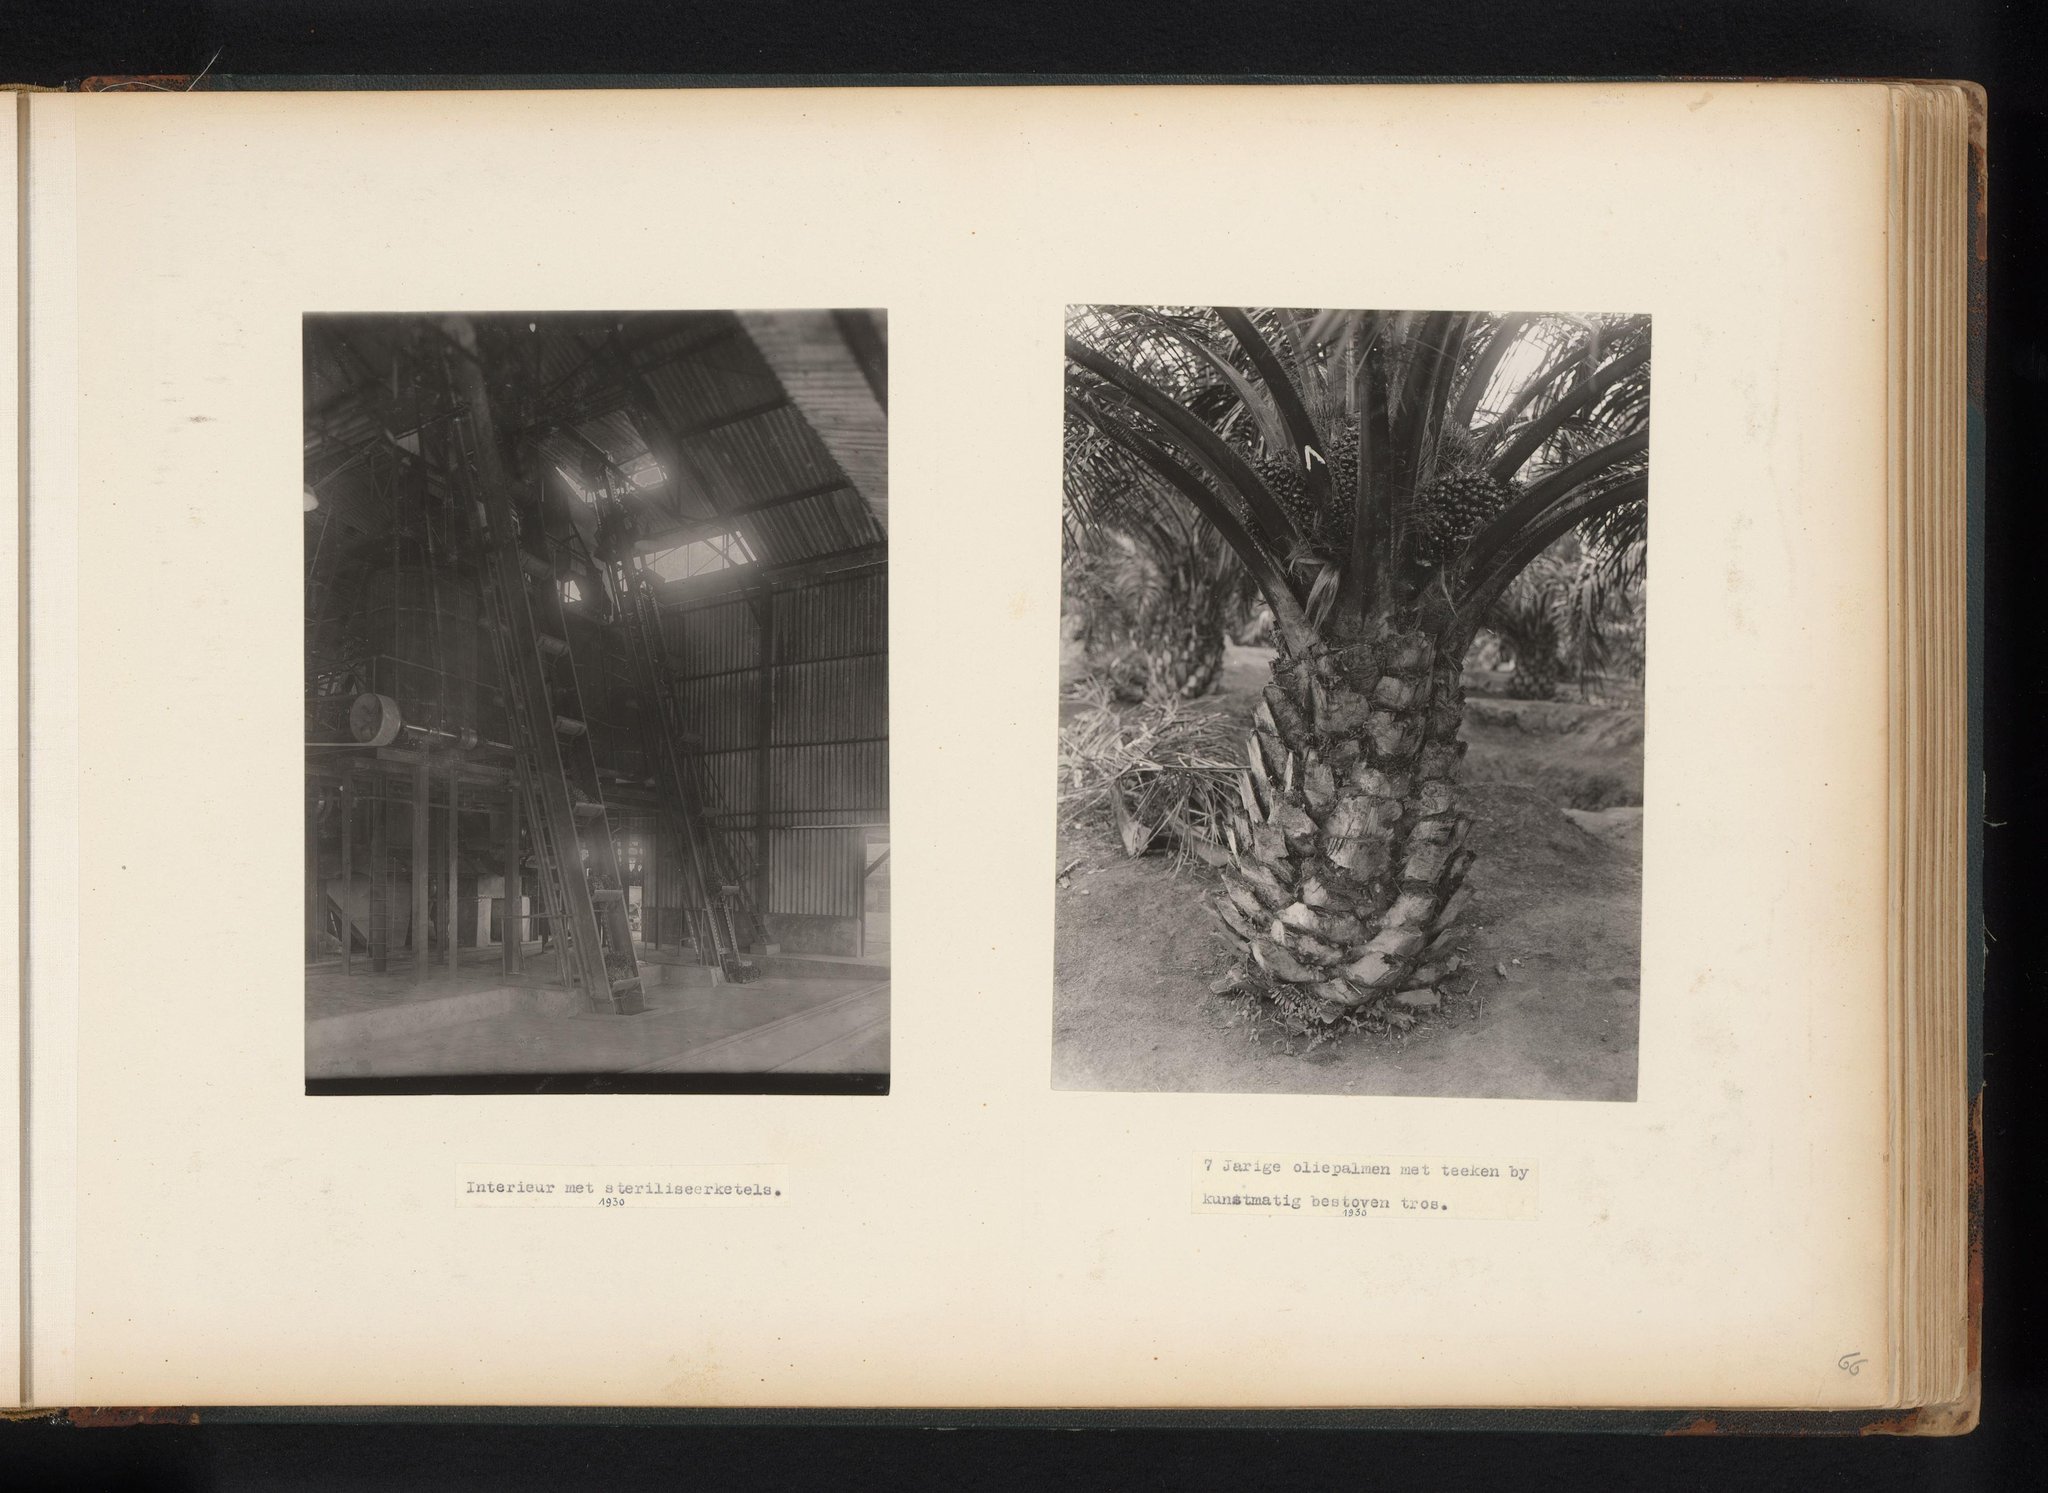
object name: photograph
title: Fabriekshal en oliepalm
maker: Anonymous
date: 1930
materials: cardboard, photographic support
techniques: gelatin silver print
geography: sumatra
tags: plantation, interior of industrial structures (regardless of the materials processed or the products made, (non-fruit) products of plants or trees: palm oil, sumatra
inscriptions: inscription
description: Blad met twee foto's van fabrieksinterieur met ketels en van een oudere oliepalm, 1930. Onder de foto's etiketten met onderschriften. Onderdeel van het fotoalbum over de plantages Brussel en Pernantian van de Sumatra Caoutchouc Maatschappij op de Oostkust van Sumatra in de jaren 1910-1935.